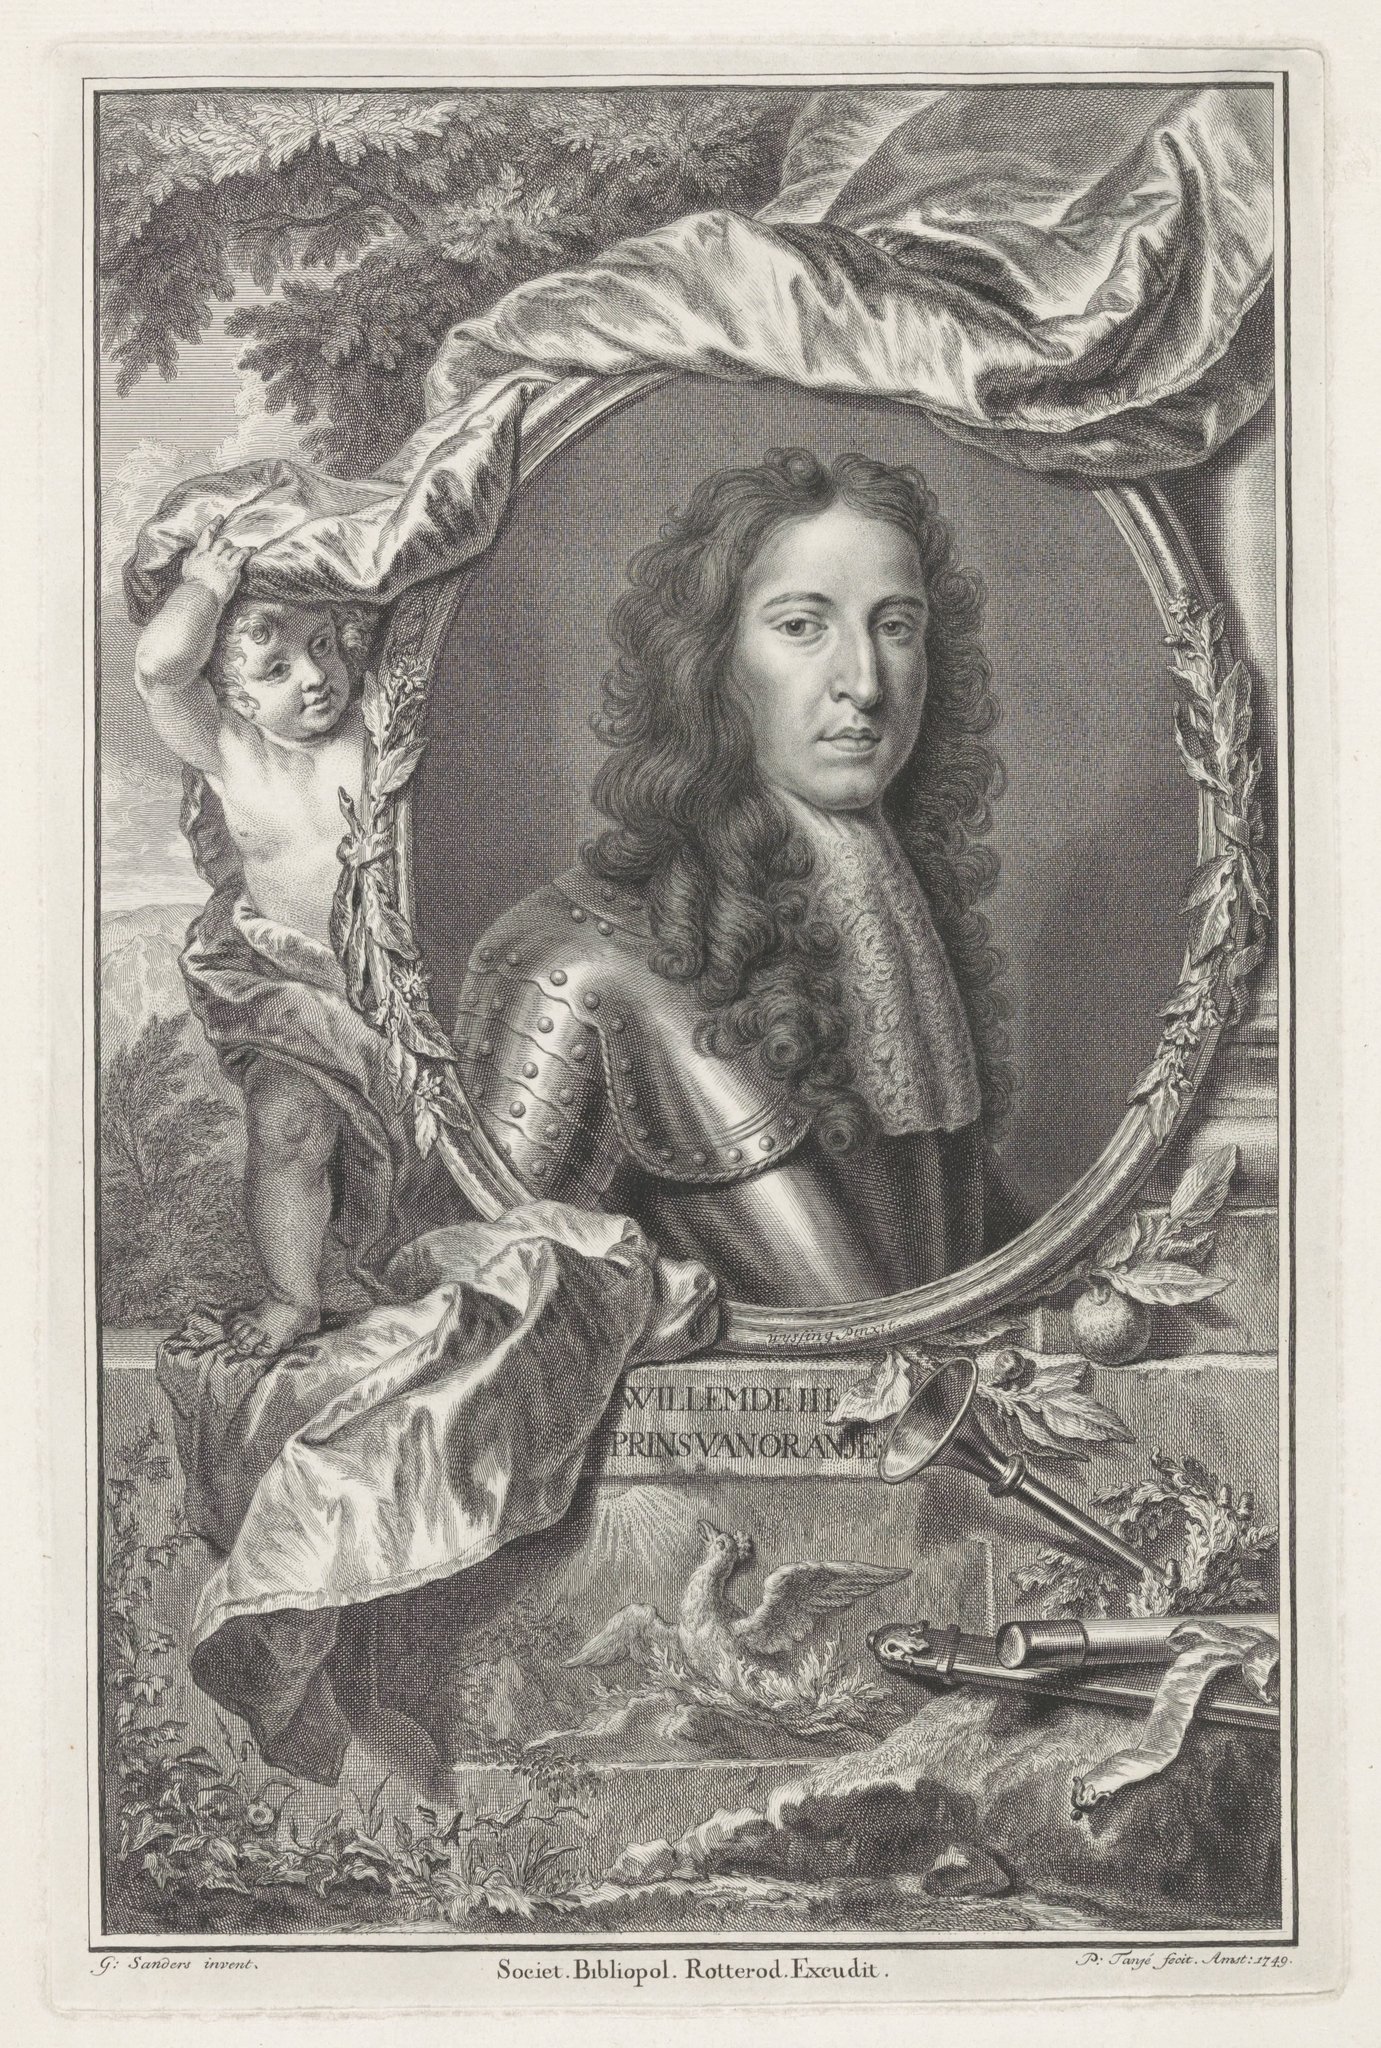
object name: print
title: Portret van Willem III, prins van Oranje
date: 1749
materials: paper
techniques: engraving, etching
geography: amsterdam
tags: the hague, william iii (prince of orange and king of england, scotland, and ireland)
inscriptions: date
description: Portret van Willem III in een ovaal. Rondom ligt een aantal allegorische objecten, waaronder een commandostaf, een lauwerkrans en een bazuin. Op het reliëf een verrijzende Phoenix en zijn naam. Daaronder losse opgeplakte handtekening met pen.